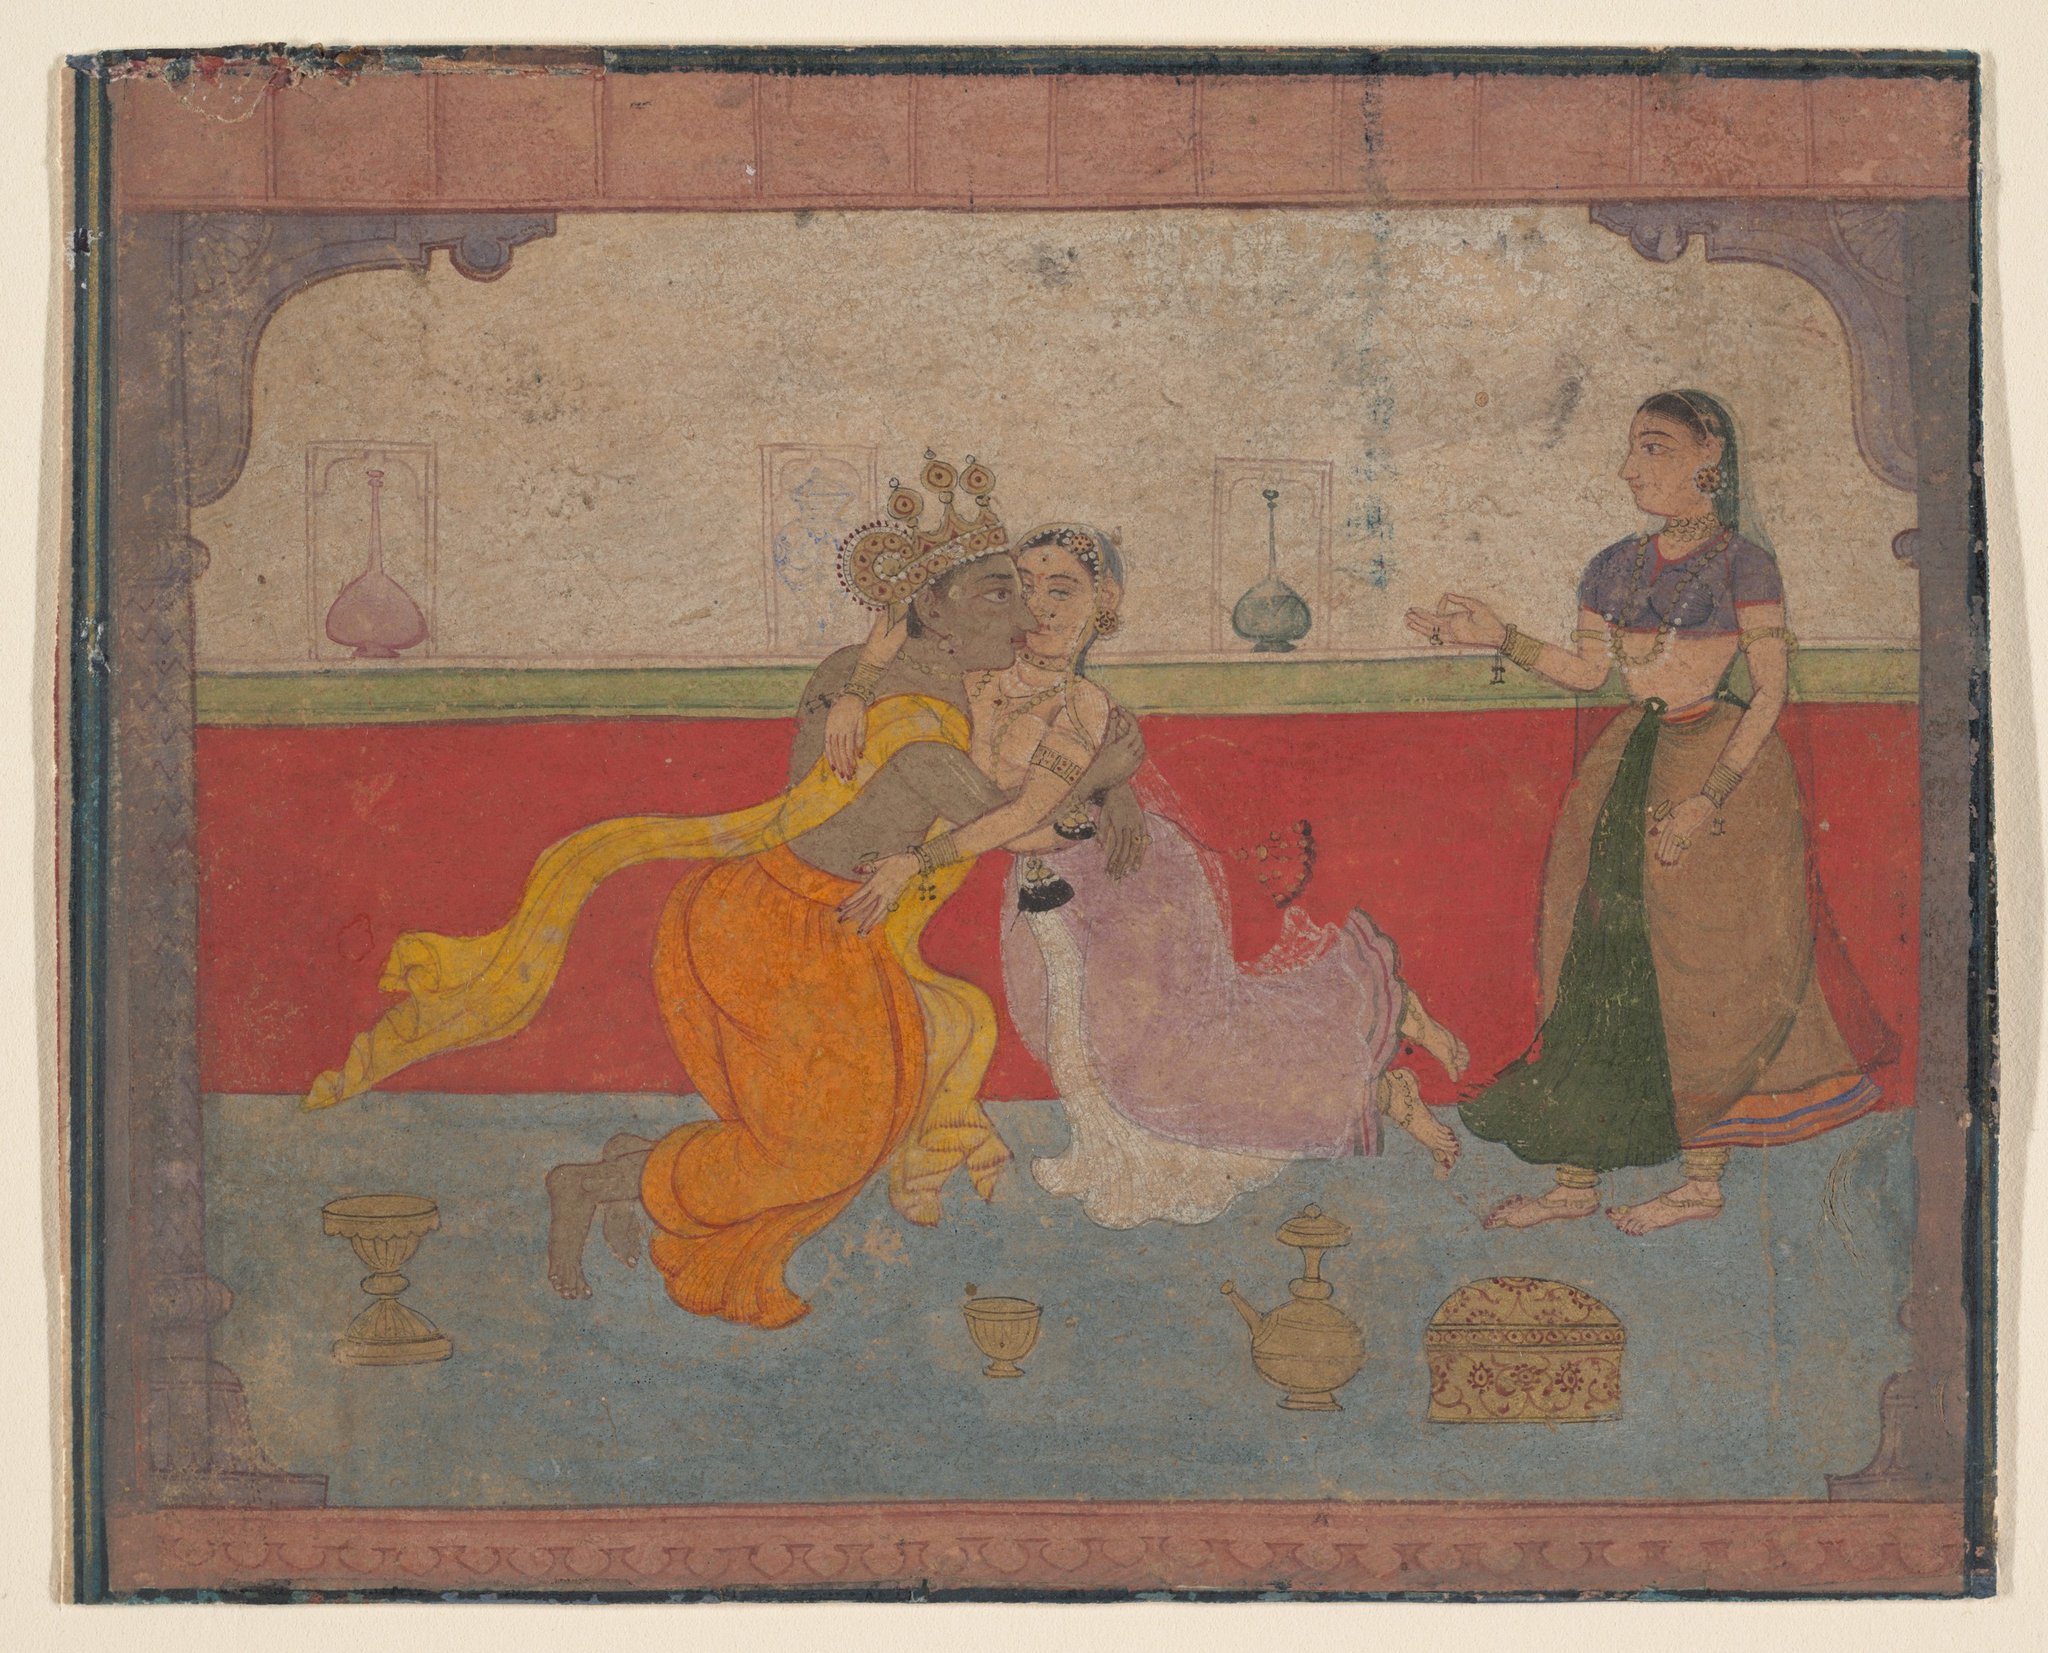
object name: folio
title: Krishna Kisses Radha: Page from the Boston Rasikapriya (Lover's Breviary)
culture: indian or rajasthan or amber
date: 1610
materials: gold, ink, paper, watercolor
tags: couples,women,krishna,radha